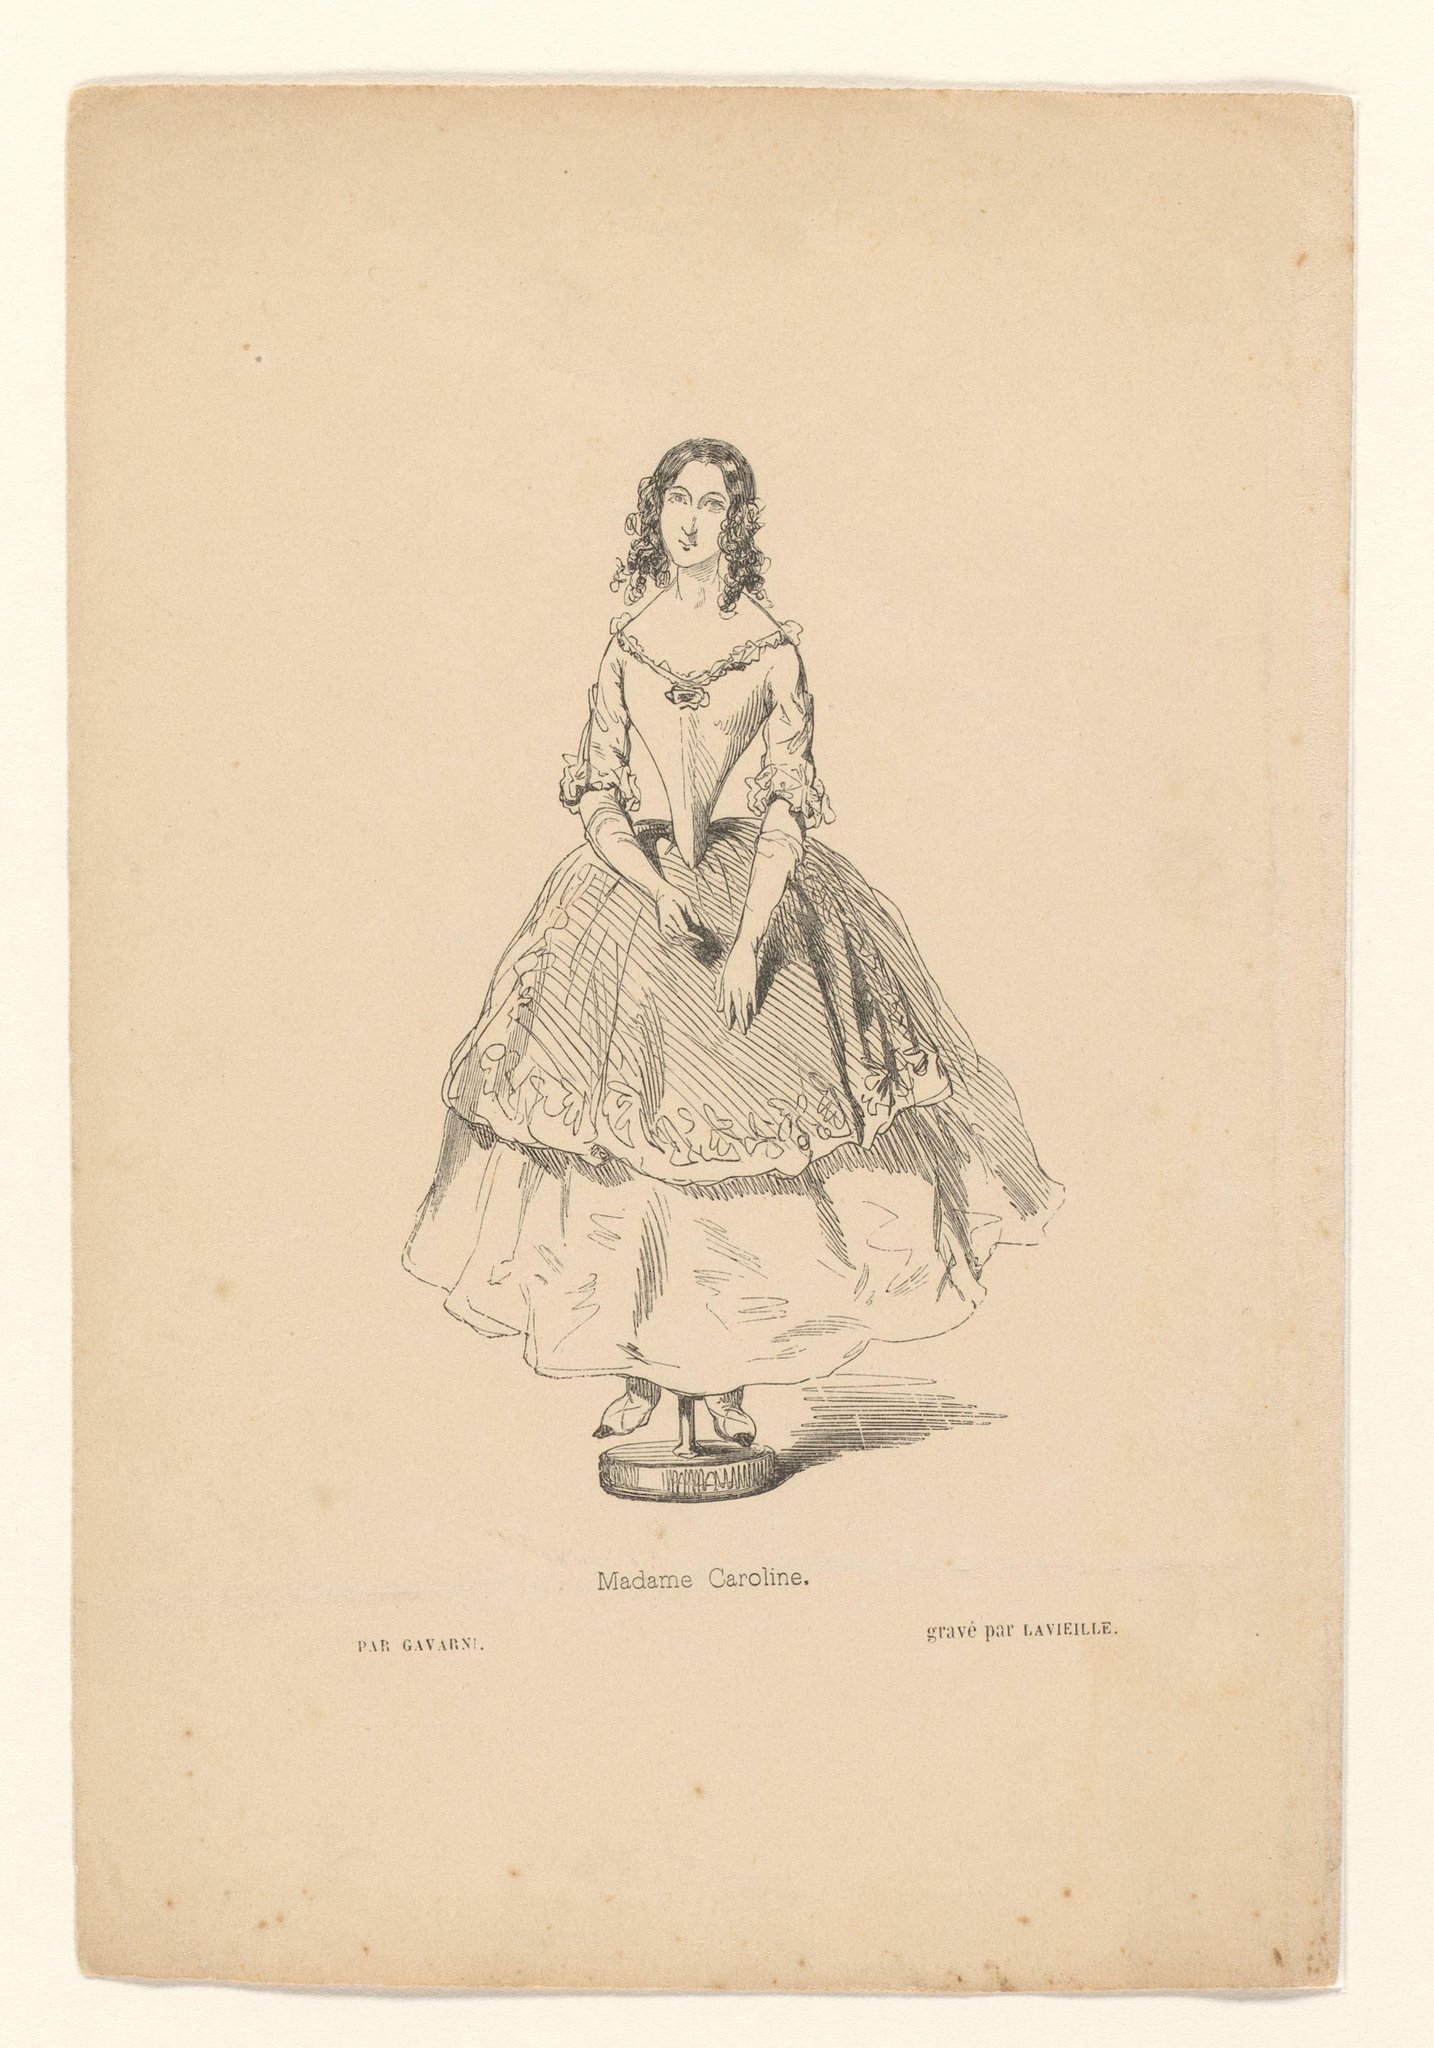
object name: print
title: Mevrouw Caroline uit Petites Misères de la Vie Conjugale van Honoré de Balzac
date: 1830-1862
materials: paper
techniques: engraving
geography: france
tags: paris, honoré de balzac, female literary characters